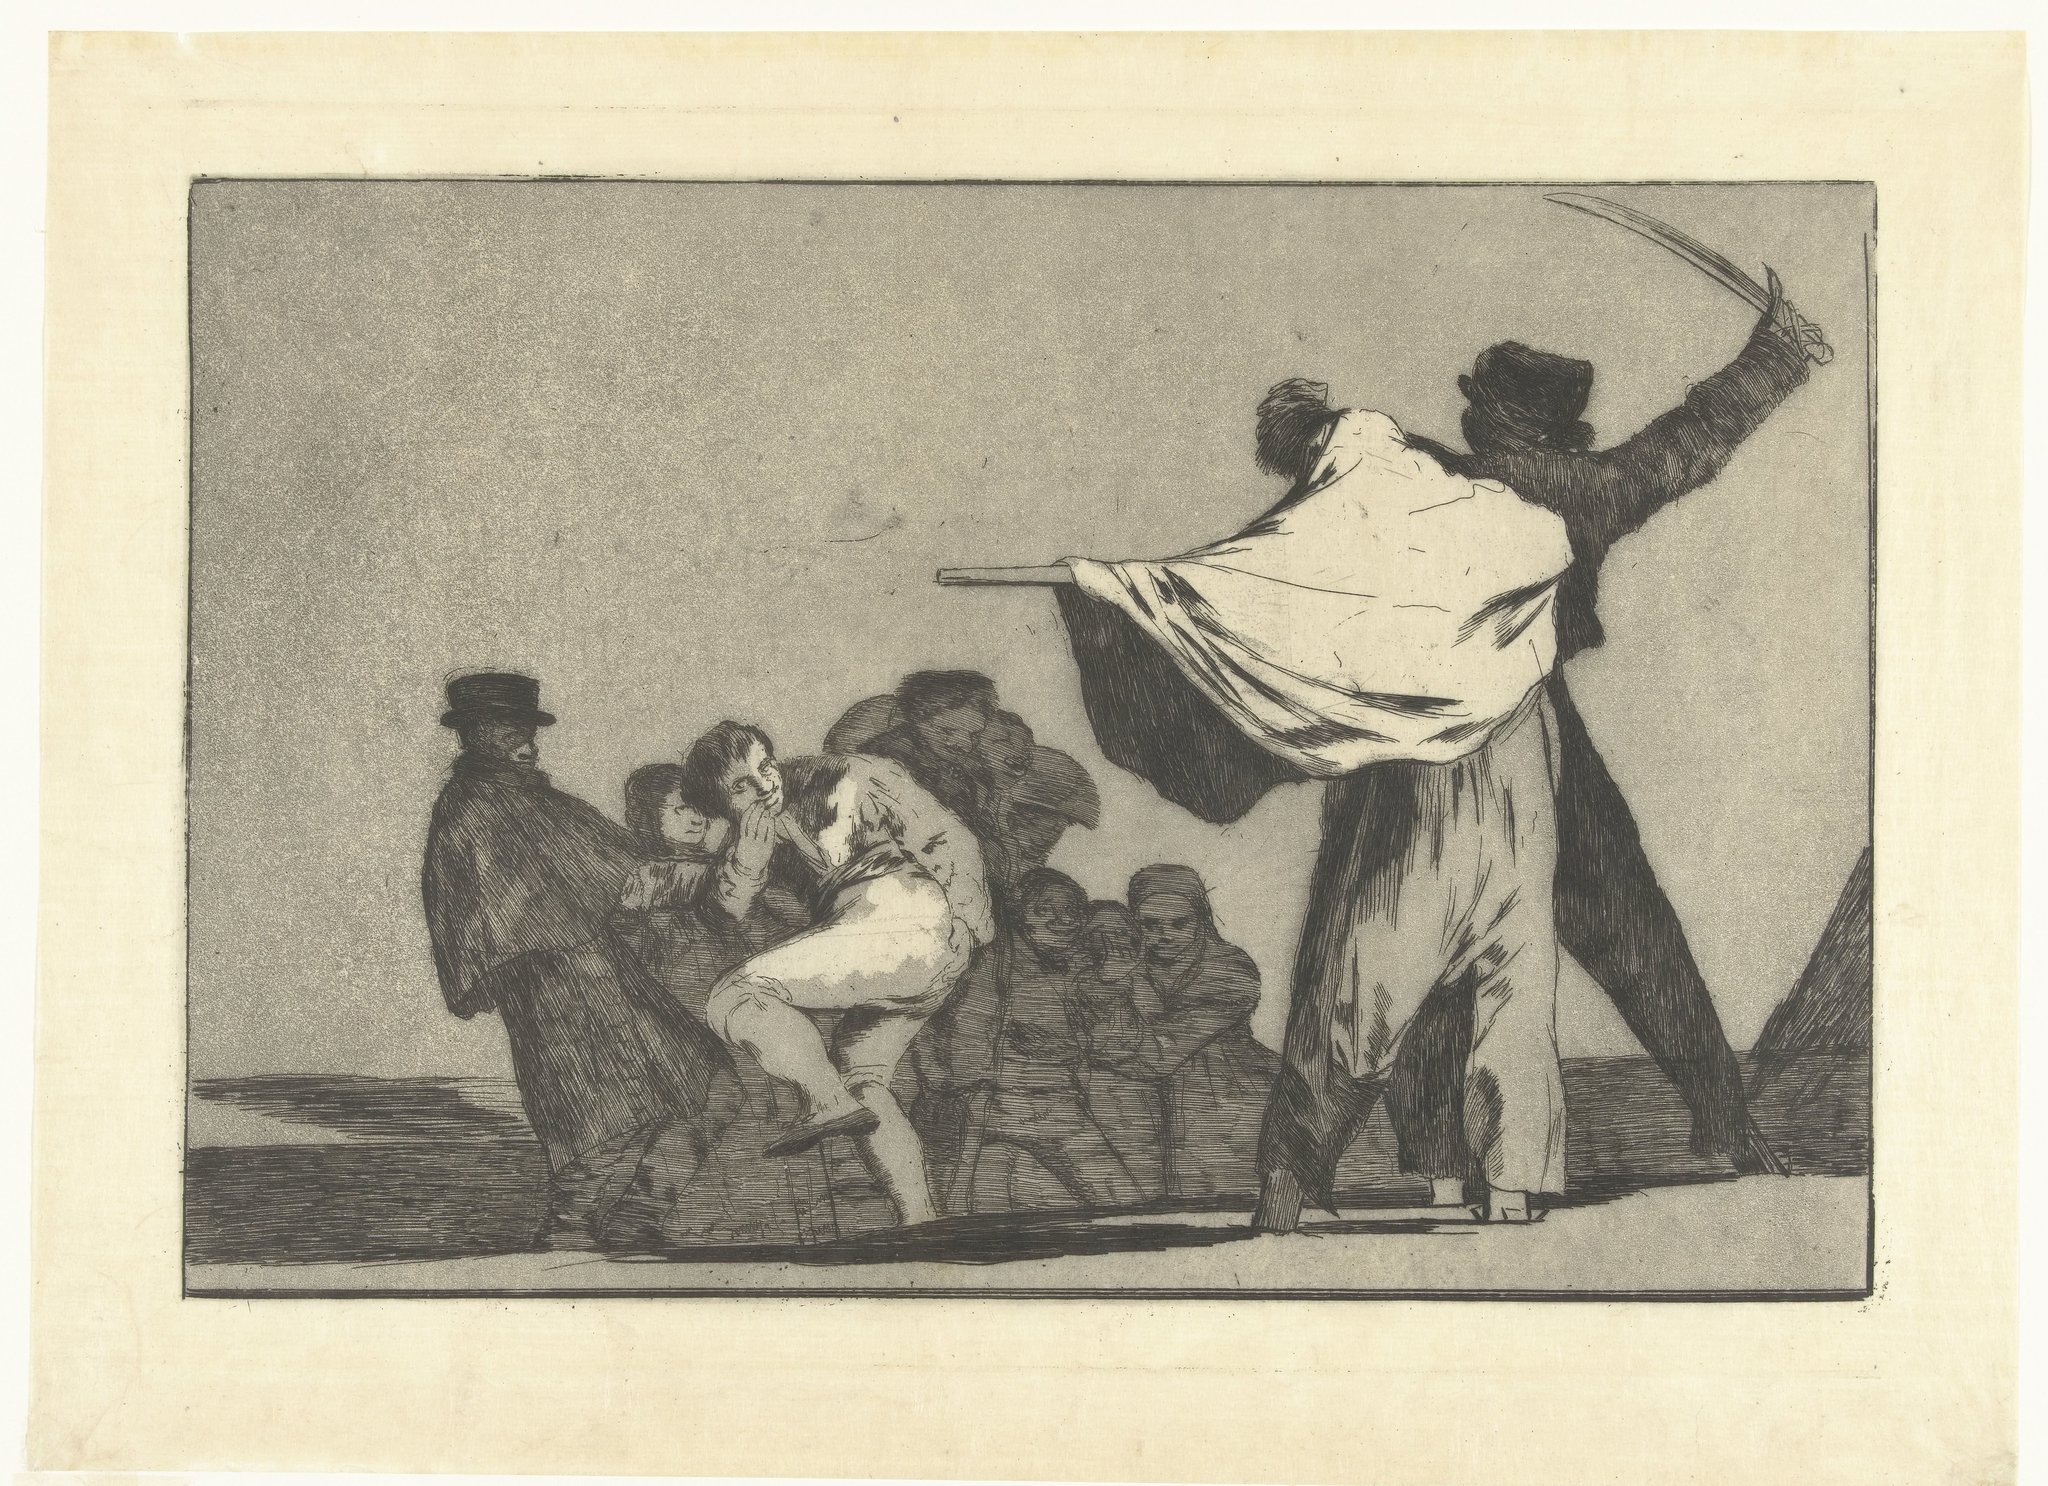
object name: print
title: Disperate Conocido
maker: francisco de goya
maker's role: draughtsman, painter, print maker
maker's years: 1746-1828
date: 1815-1820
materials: paper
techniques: aquatint, etching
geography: spain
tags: proverbs, sayings, etc., morphology of human expression (+ laughing at a person), scarecrow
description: De serie Los Disparates is pas na de dood van Goya uitgegeven. De Real Academia des Nobles Artes heeft de serie gepubliceerd onder de naam Los Proverbios. Harris heeft in zijn catalogus aan elke prent een Spaans spreekwoord toegekend. Deze prent verbeeldt volgens hem het spreekwoord: "Dos e uno, meten la paja en el culo"(als het één tegen twee is, stop stro in je kont). K.Botke